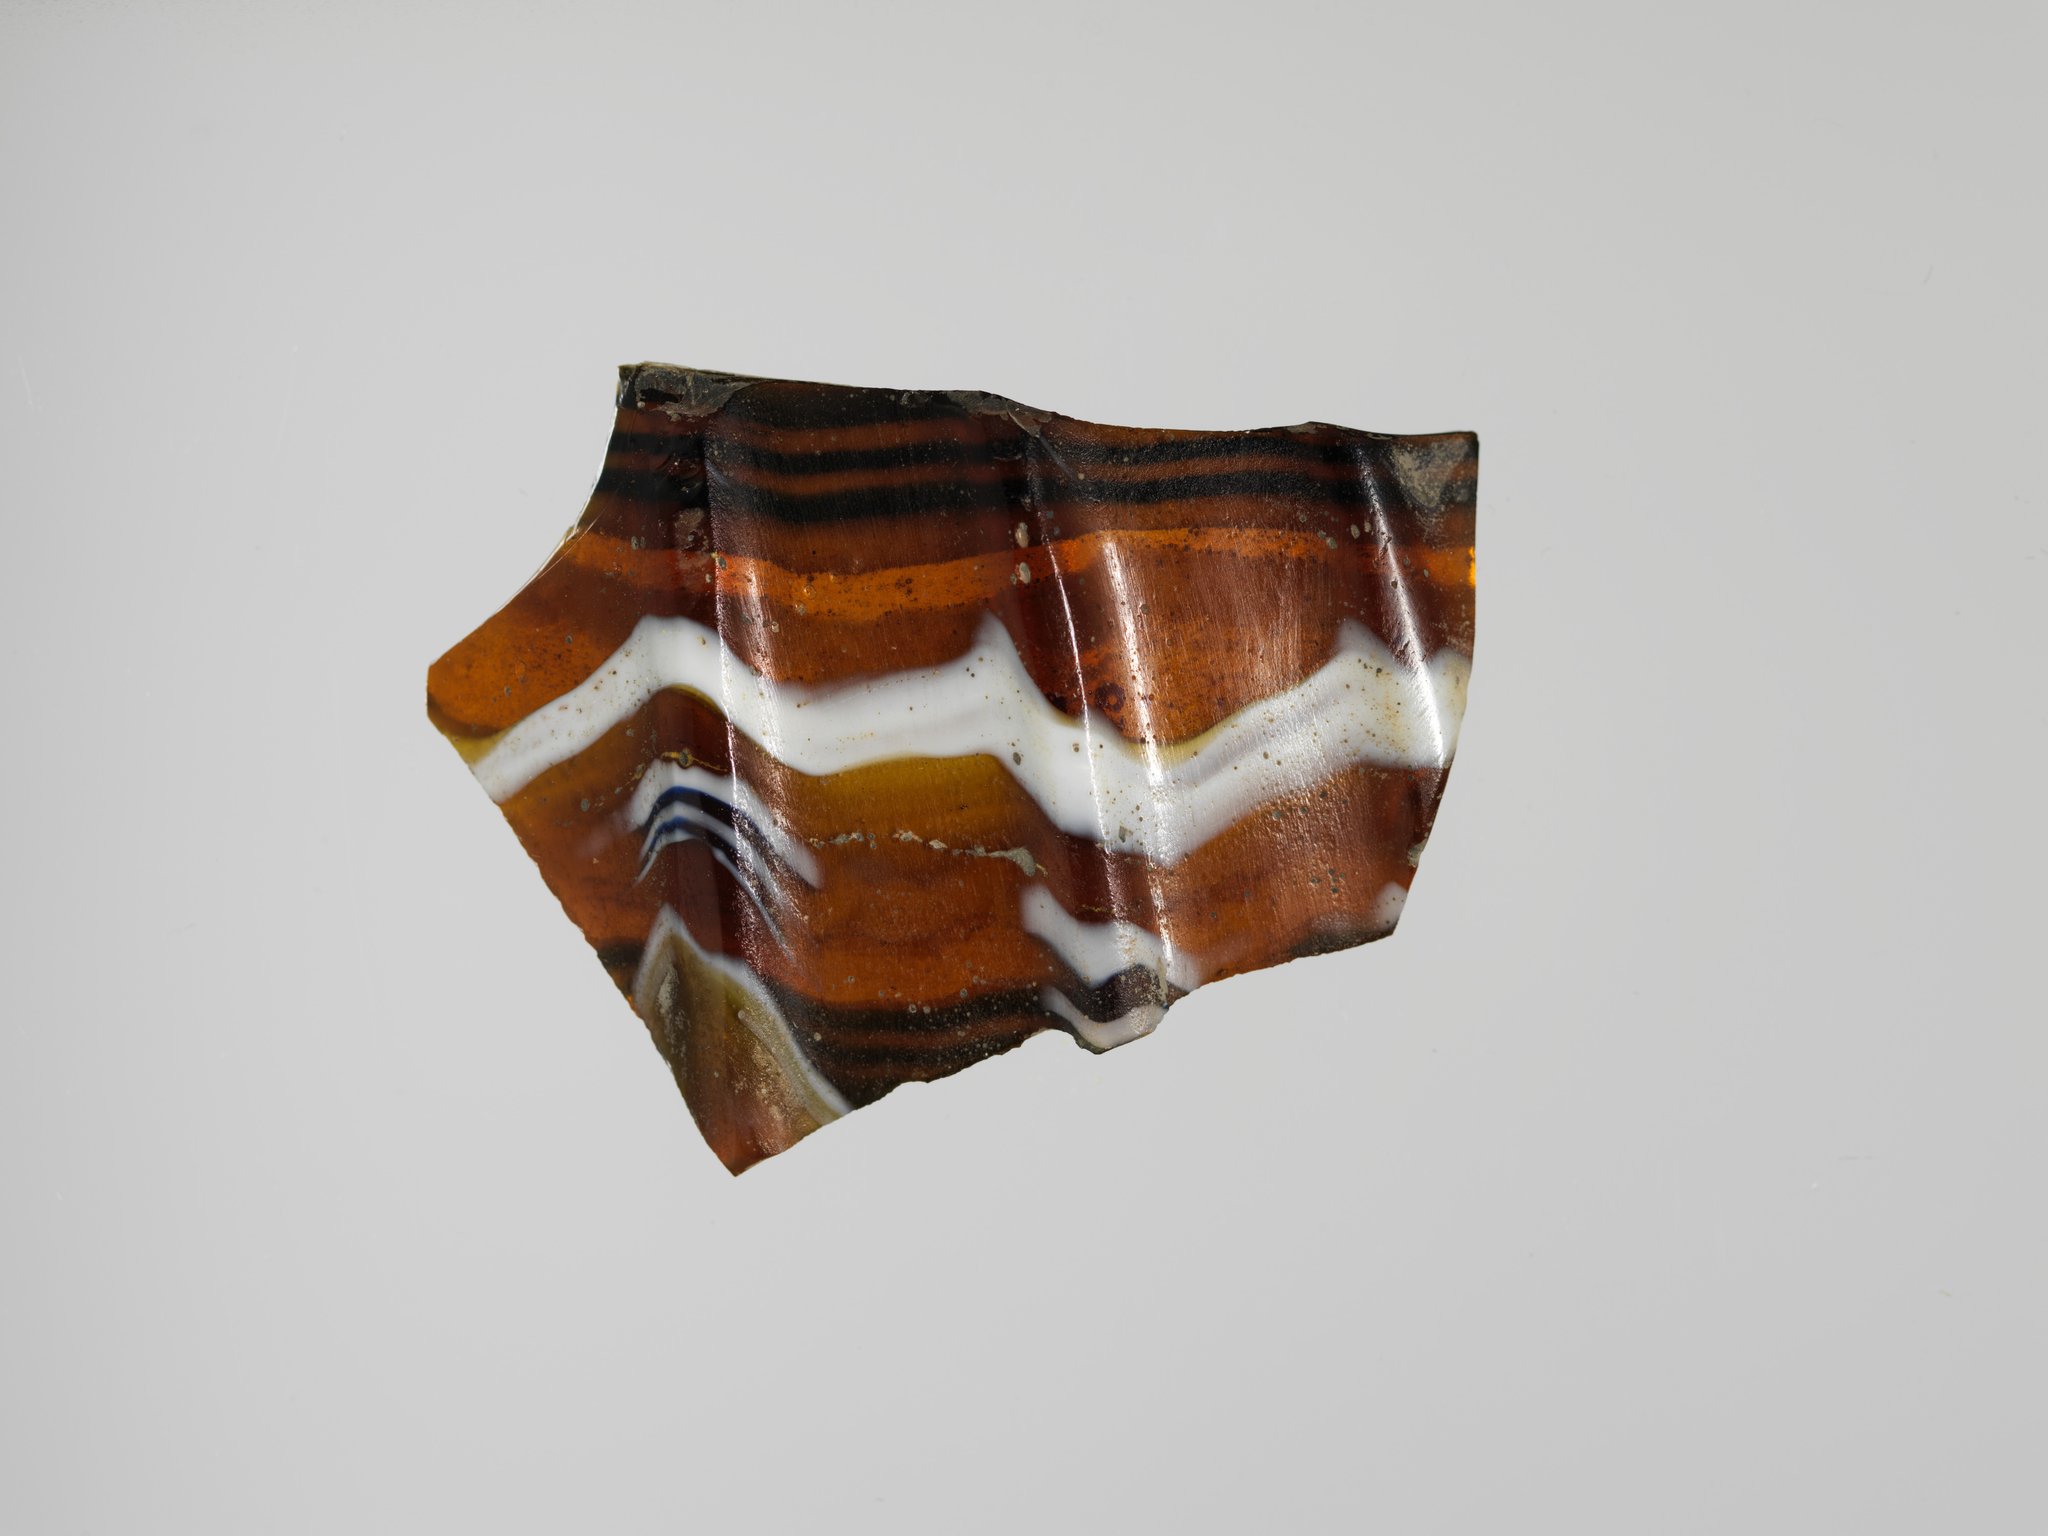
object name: fragment, mosaic bowl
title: Glass mosaic ribbed bowl fragment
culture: roman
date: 34 BCE-33 CE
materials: glass